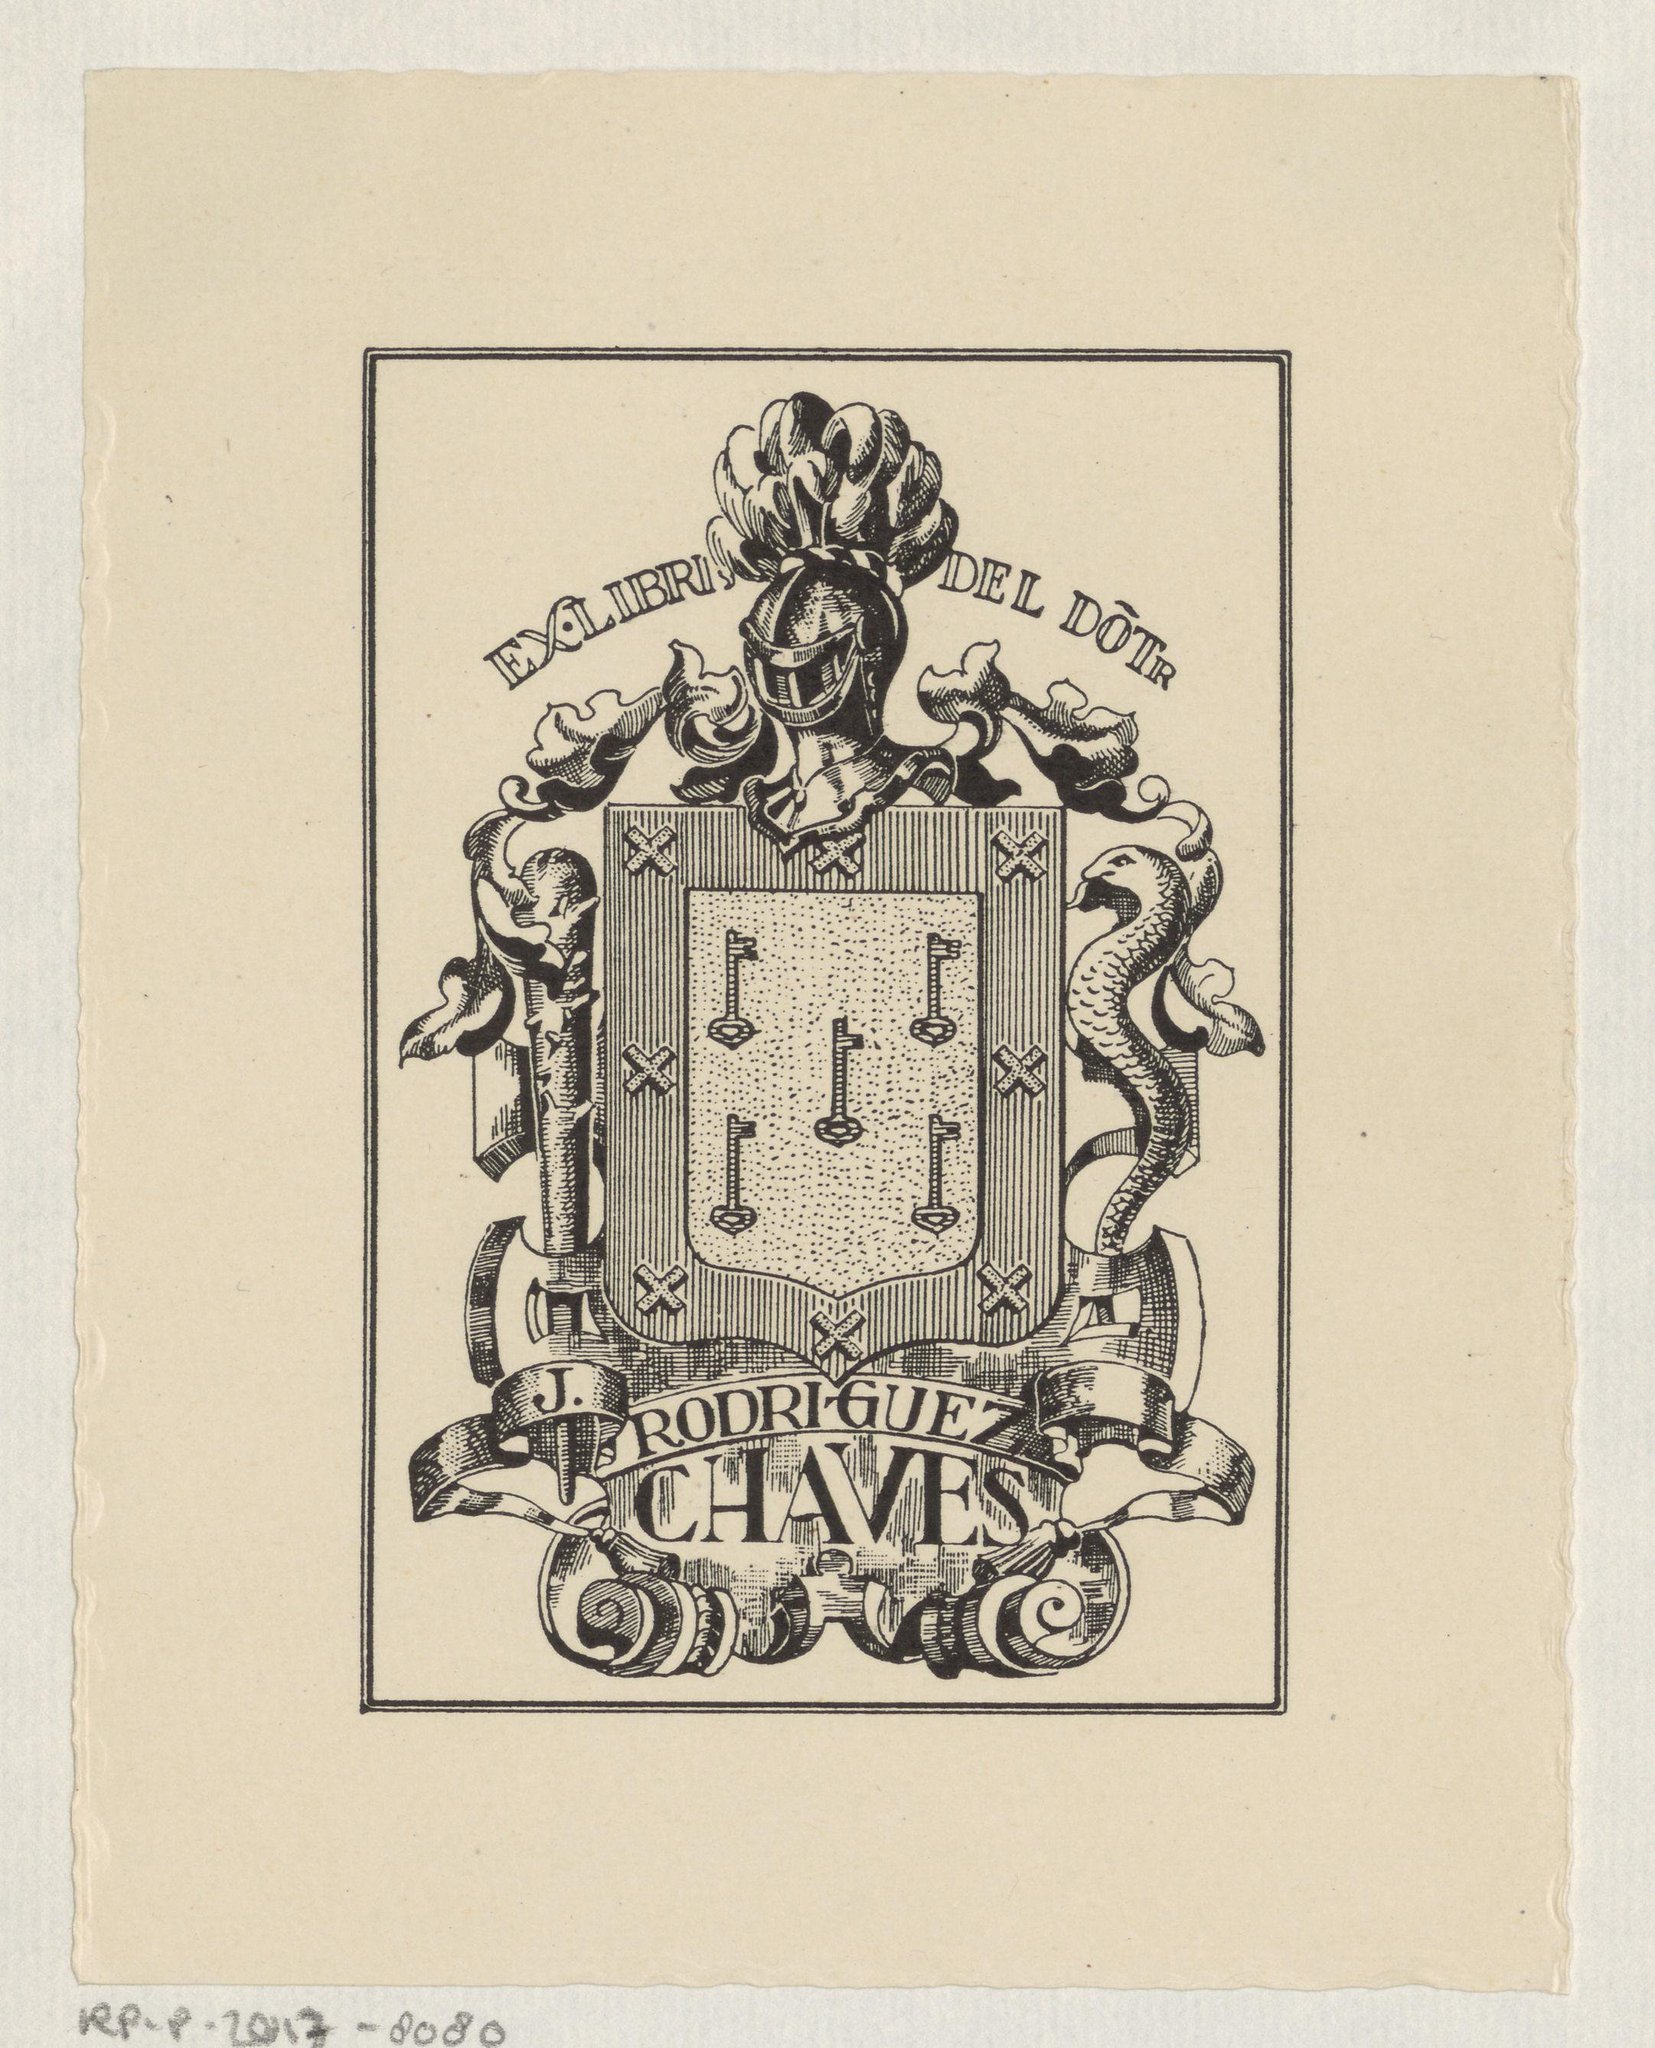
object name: bookplate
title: Ex libris van José Rodríguez Chaves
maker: Anonymous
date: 1900-1999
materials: paper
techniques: printing block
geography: spain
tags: josé rodriguez chaves, key, armorial bearing, heraldry